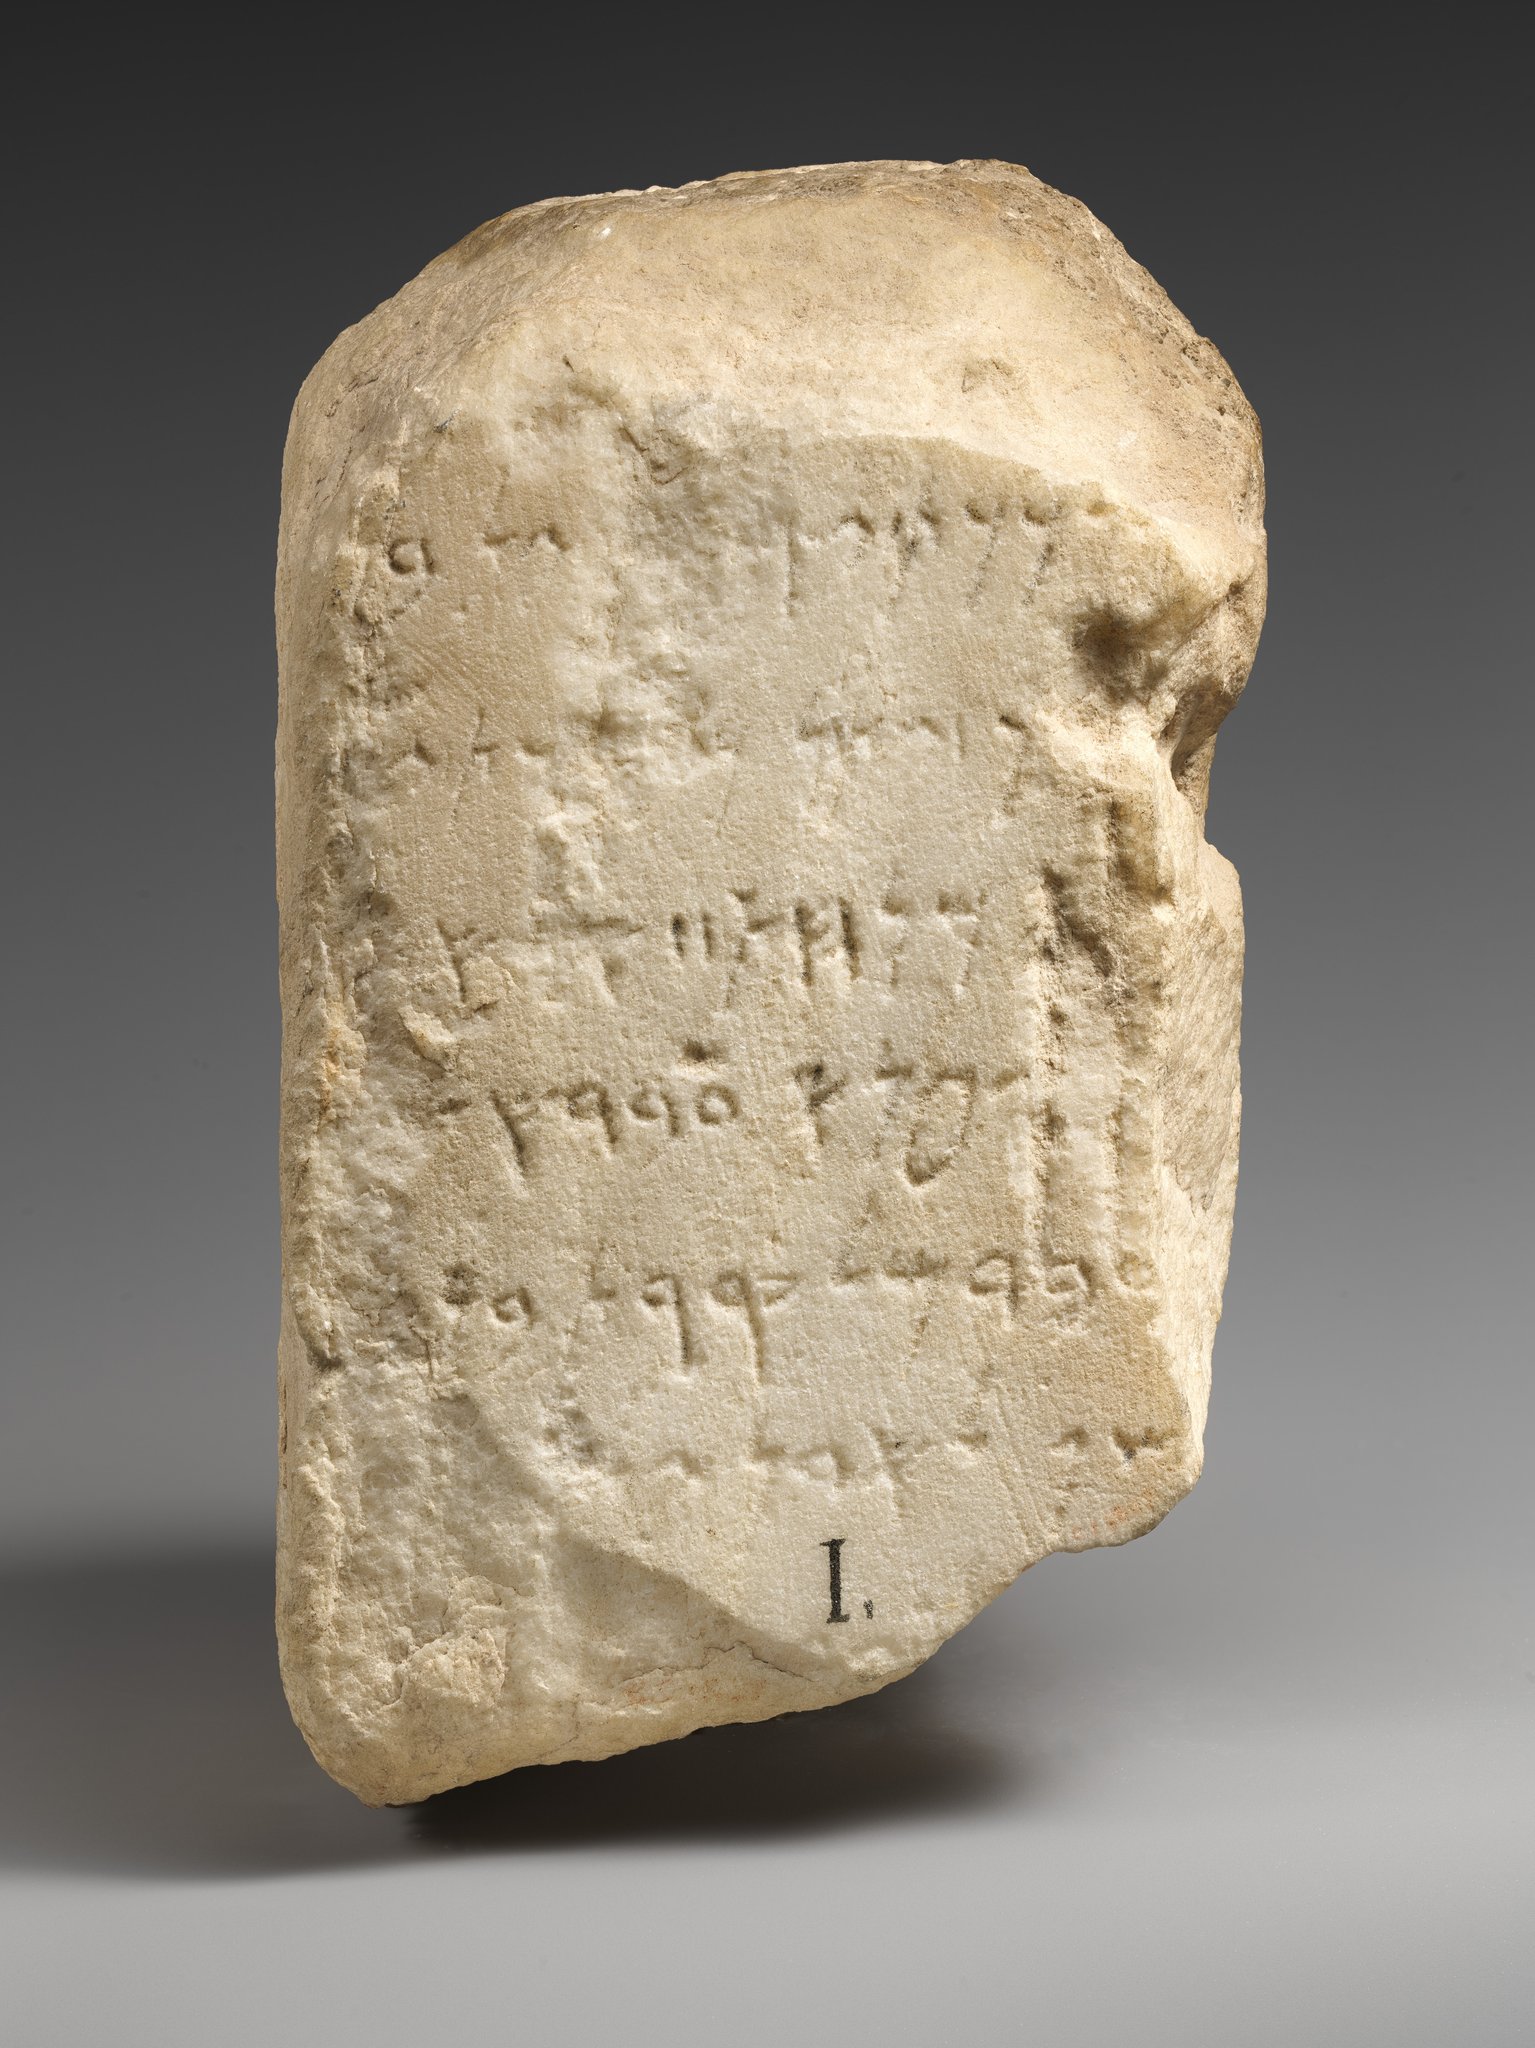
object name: cippus with phoenician inscription, fragmentary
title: Marble cippus with Phoenician inscription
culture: cypriot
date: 362-312 BCE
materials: marble